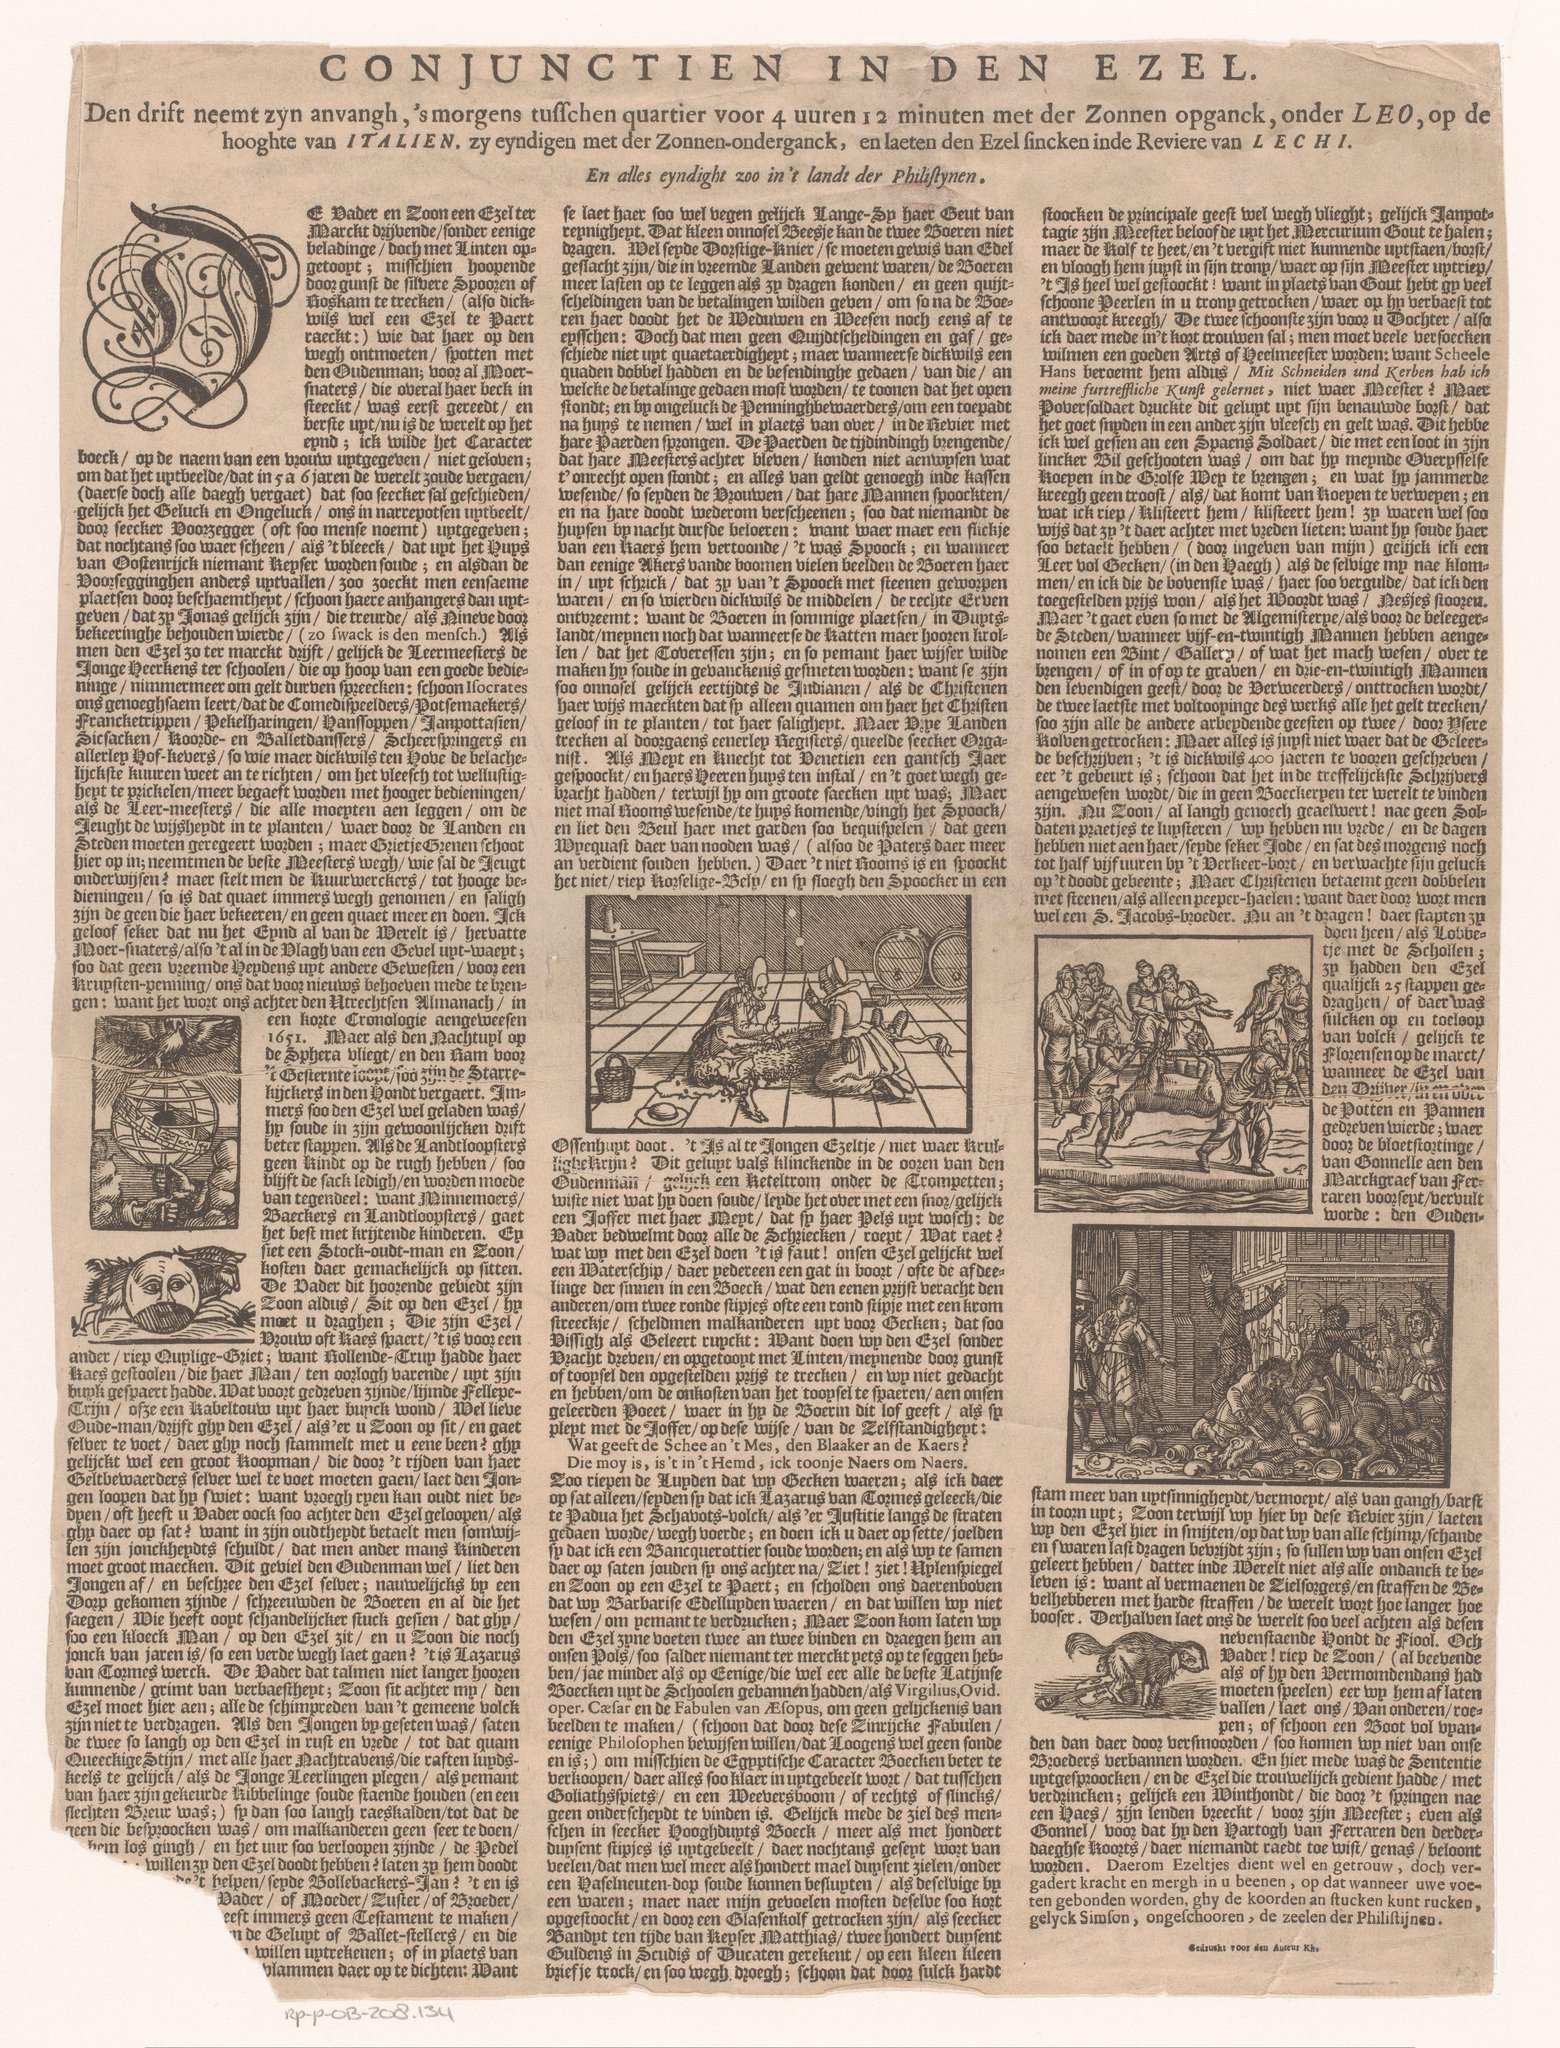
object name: print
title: Conjunctien in den ezel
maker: Anonymous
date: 1650-1749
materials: paper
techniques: letterpress printing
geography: netherlands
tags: ass, donkey, the heavens (celestial bodies)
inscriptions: collector's mark: Lugt 2228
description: Zes voorstellingen van een wereldbol met de tekens van de dierenriem, de maan met een ram, een dier dat door twee vrouwen gevild wordt, een ezel die op een draagstok gedragen wordt, een ezel die door een menigte geslacht wordt en een hond die zijn behoefte doet op een viool. Daar omheen drie kolommen met Nederlandse tekst in boekdruk over de samenstand van hemellichamen en een ezel die uiteindelijk geslacht zal worden.